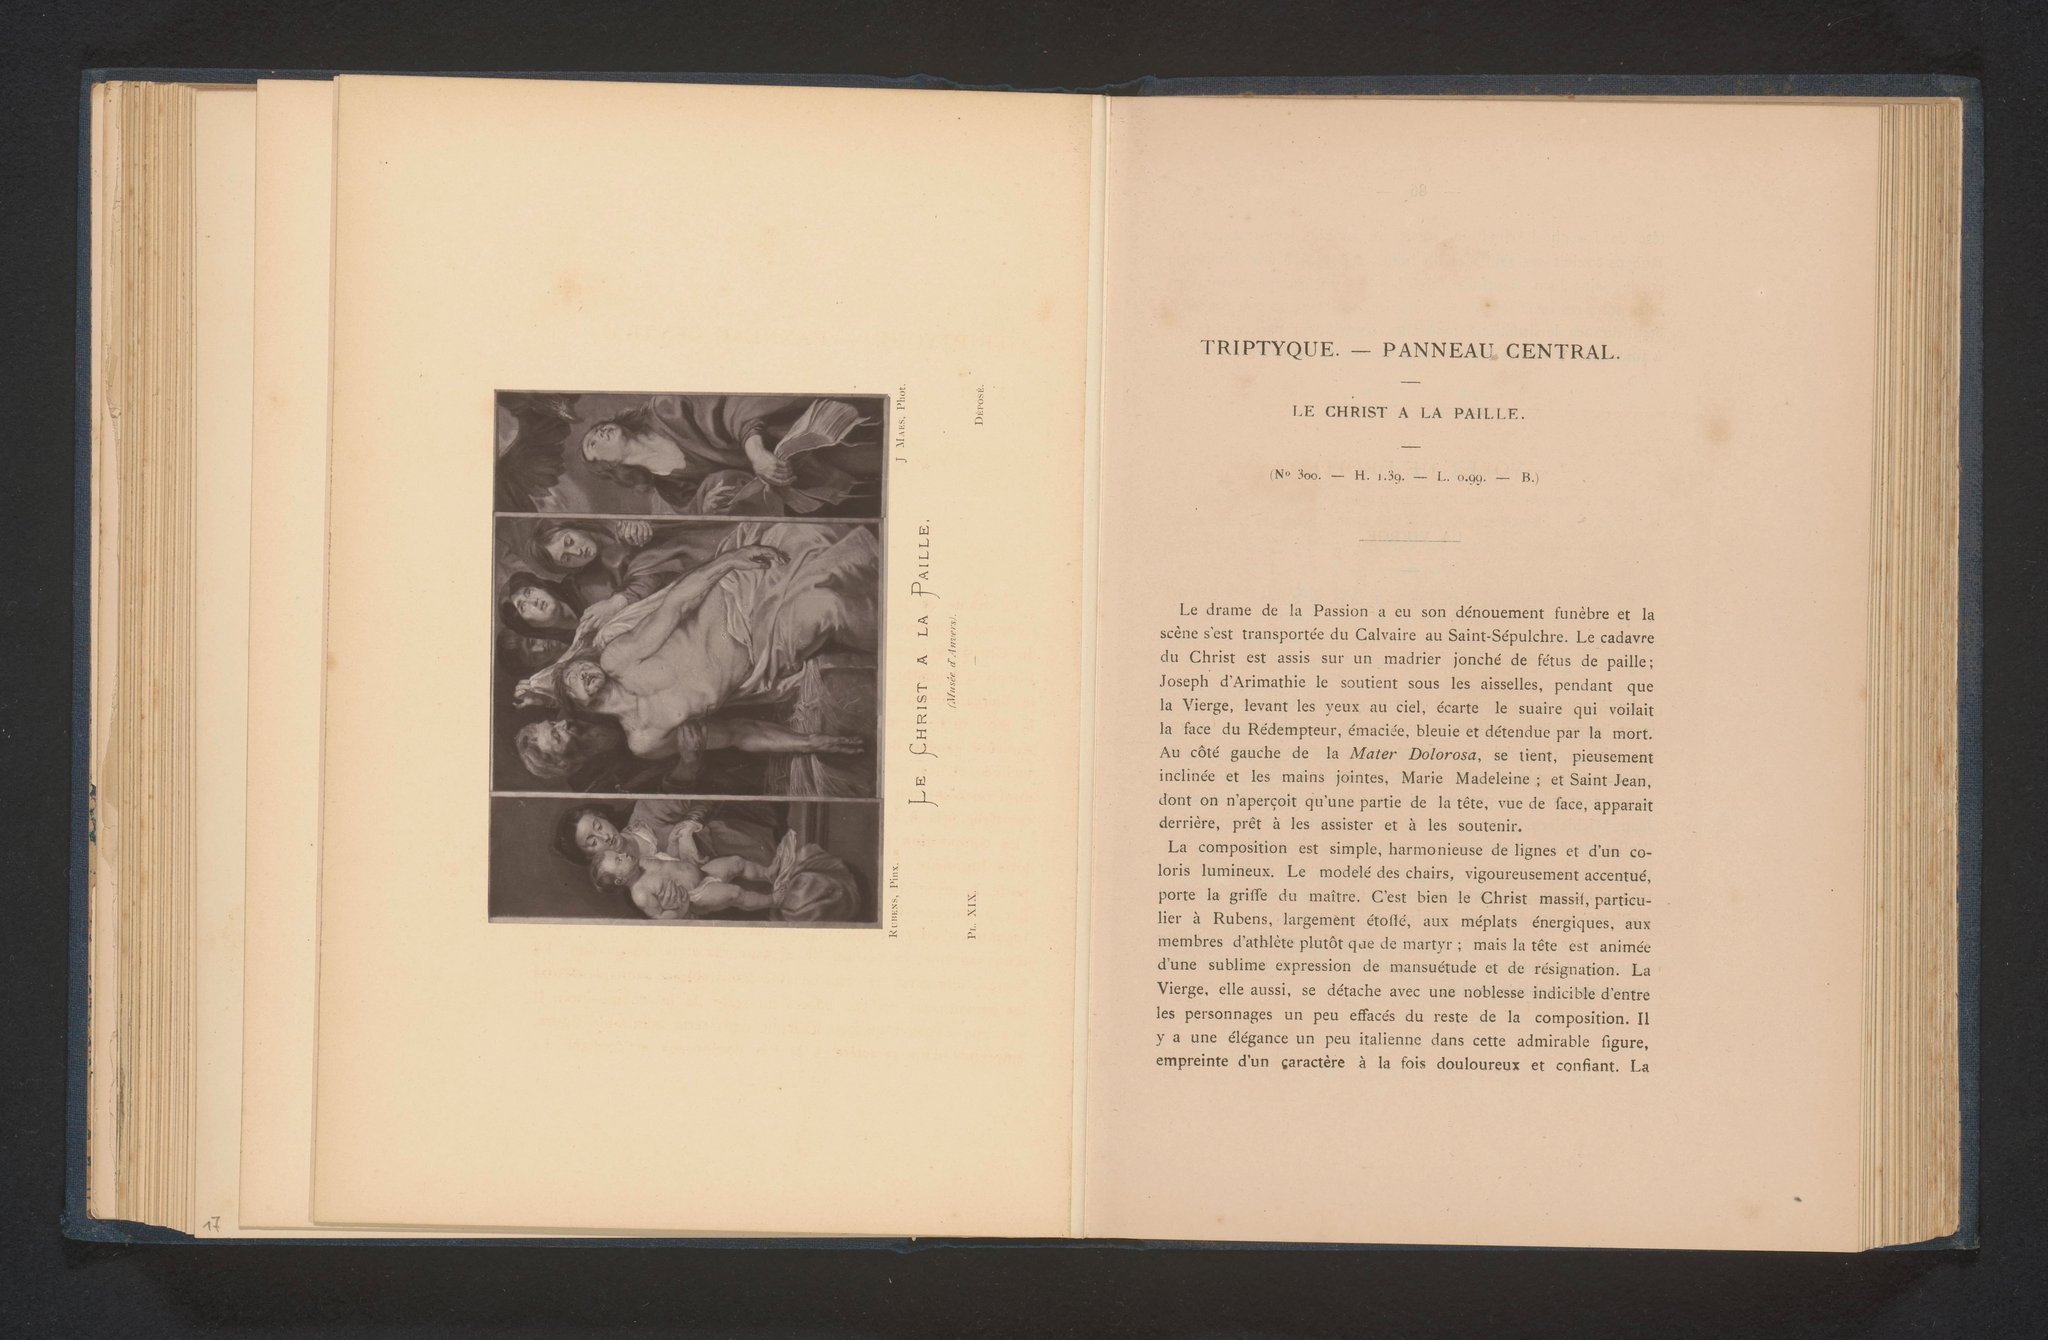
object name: reproduction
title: Le Christ a la Paille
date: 1872-1877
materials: paper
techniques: woodburytype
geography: antwerp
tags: christ's body supported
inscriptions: inscription: ‘(Musée d'Anvers)/ Pl. XIX. Déposé.’